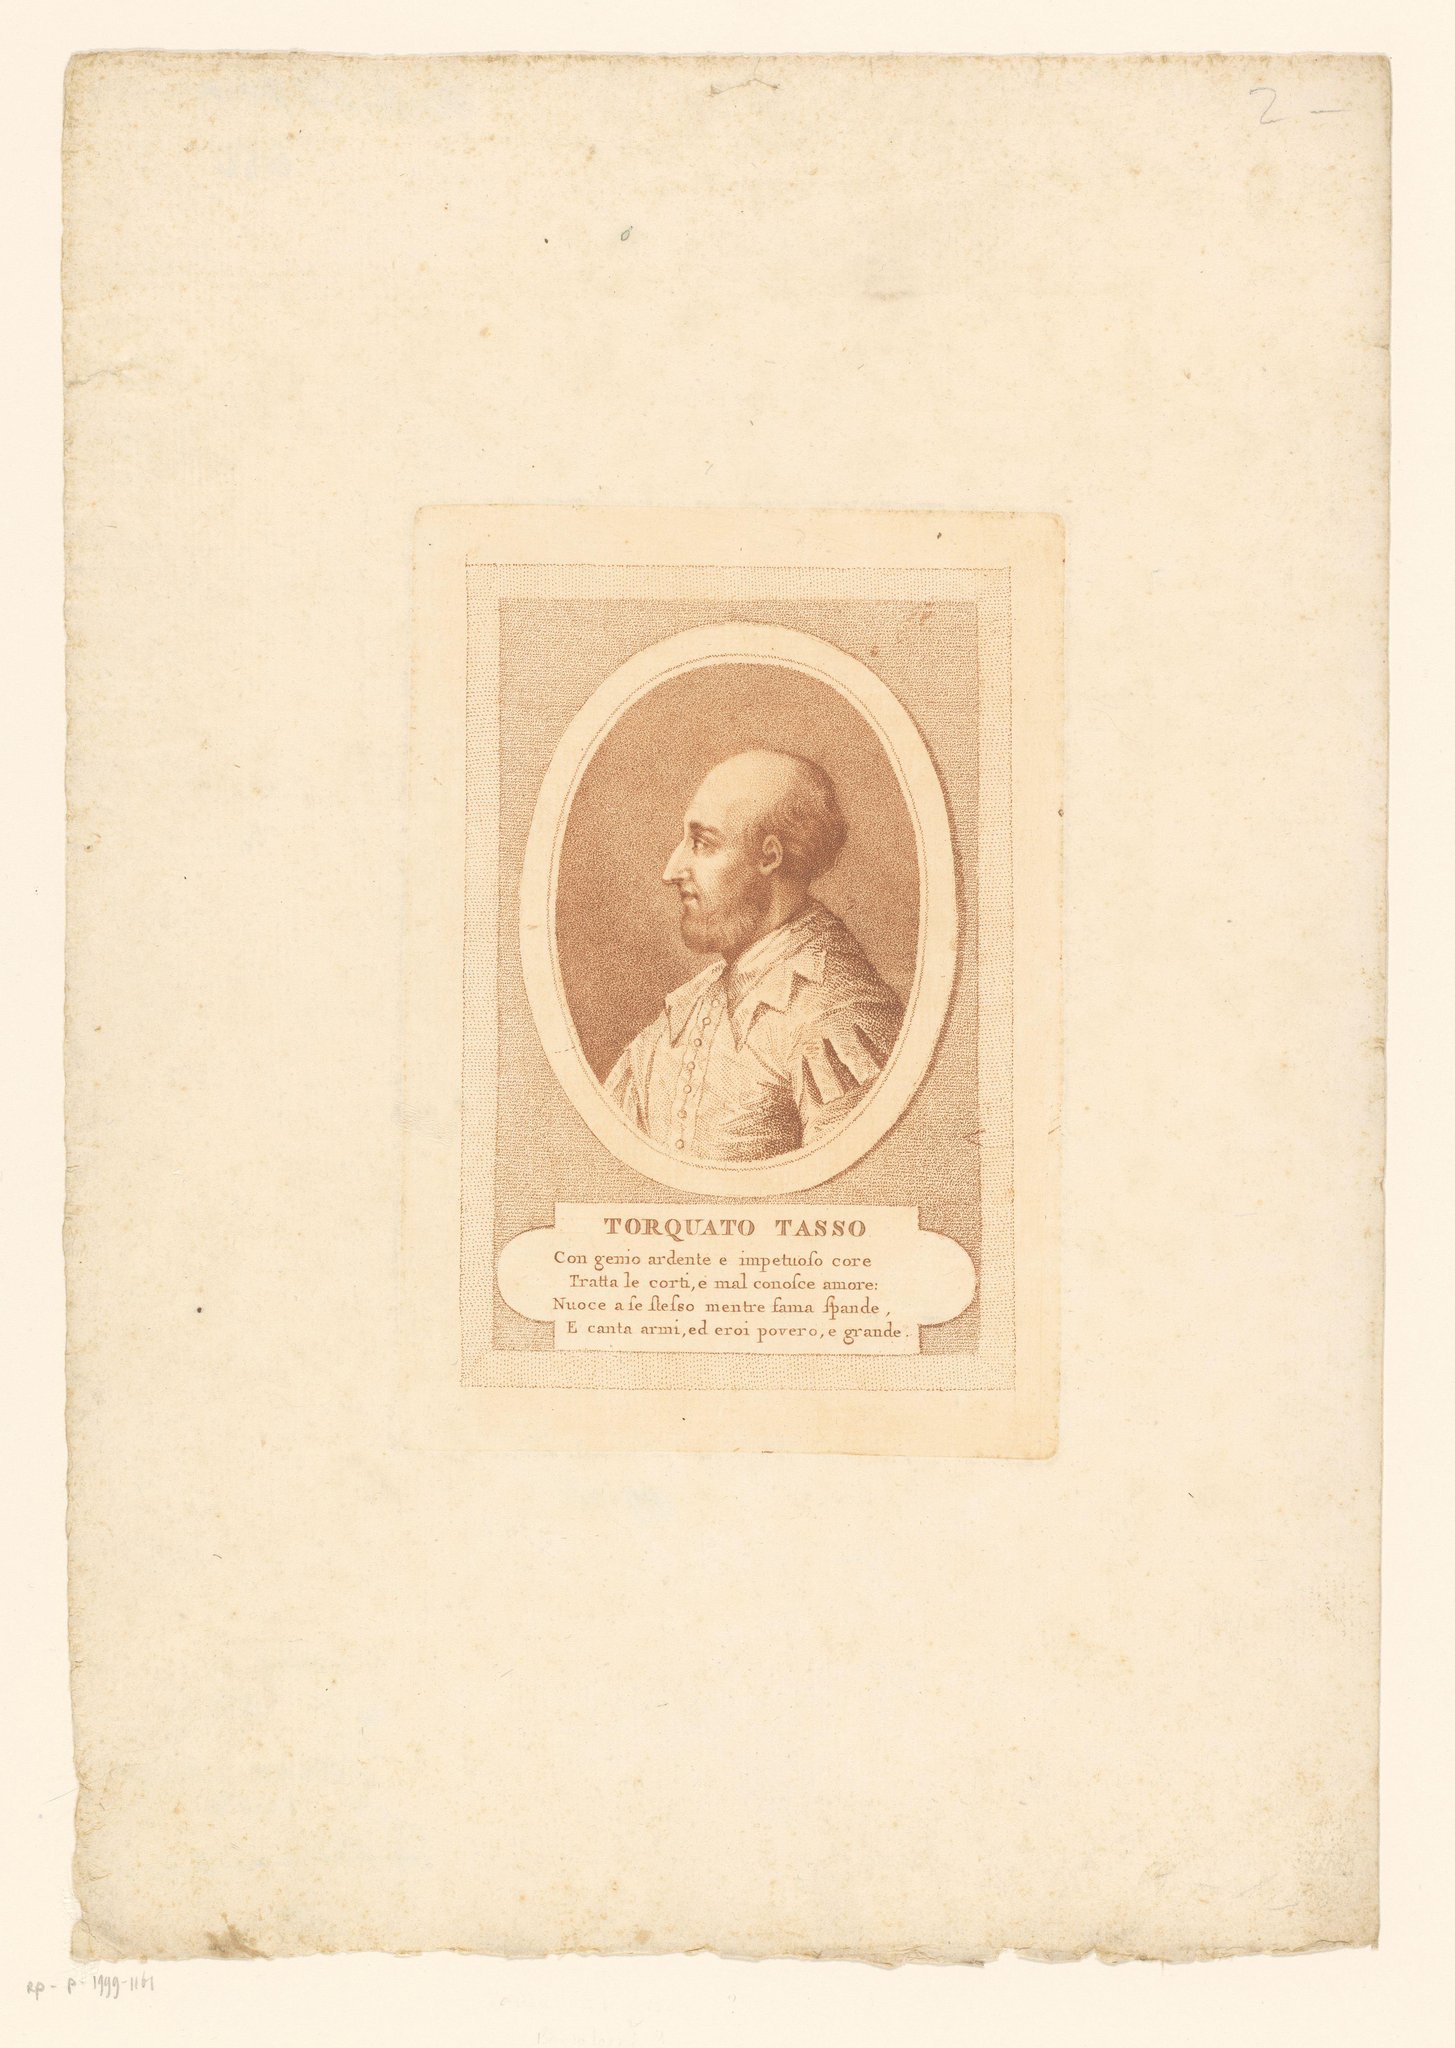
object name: print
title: Portret van Torquato Tasso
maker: Anonymous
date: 1750-1800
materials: paper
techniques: engraving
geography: italy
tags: rome, torquato tasso, historical persons, portrait of a writer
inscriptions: collector's mark: Lugt 2228, collector's mark: Lugt 2760